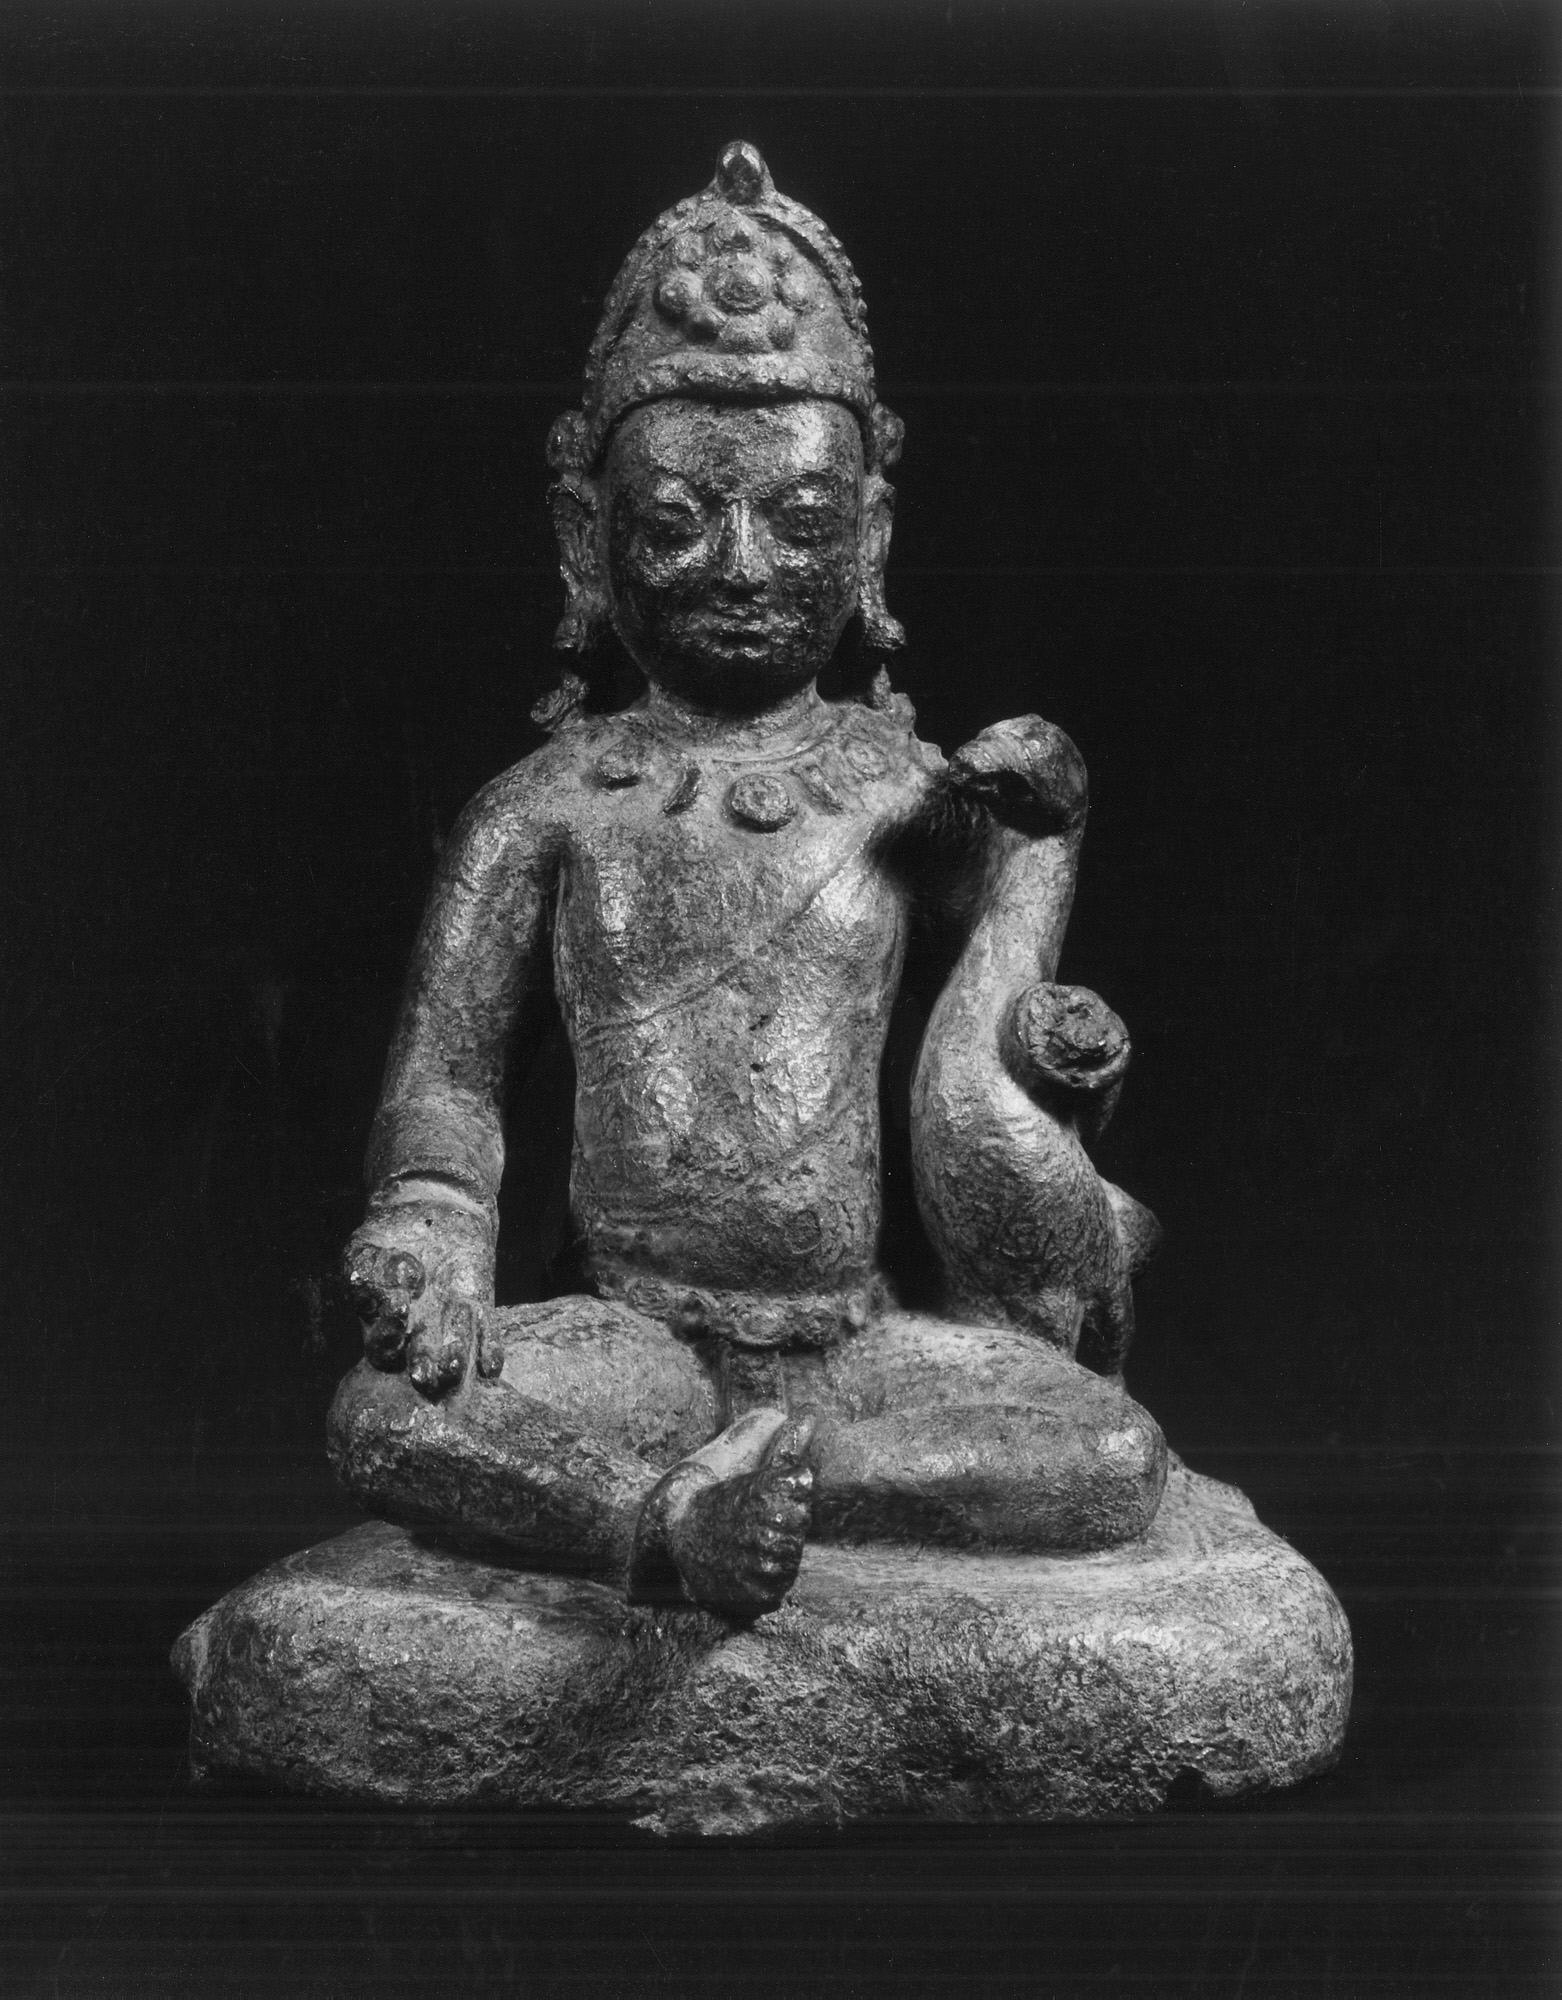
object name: figure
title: Kumara with a Peacock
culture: nepali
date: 1001-1100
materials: copper alloy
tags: men,peacocks